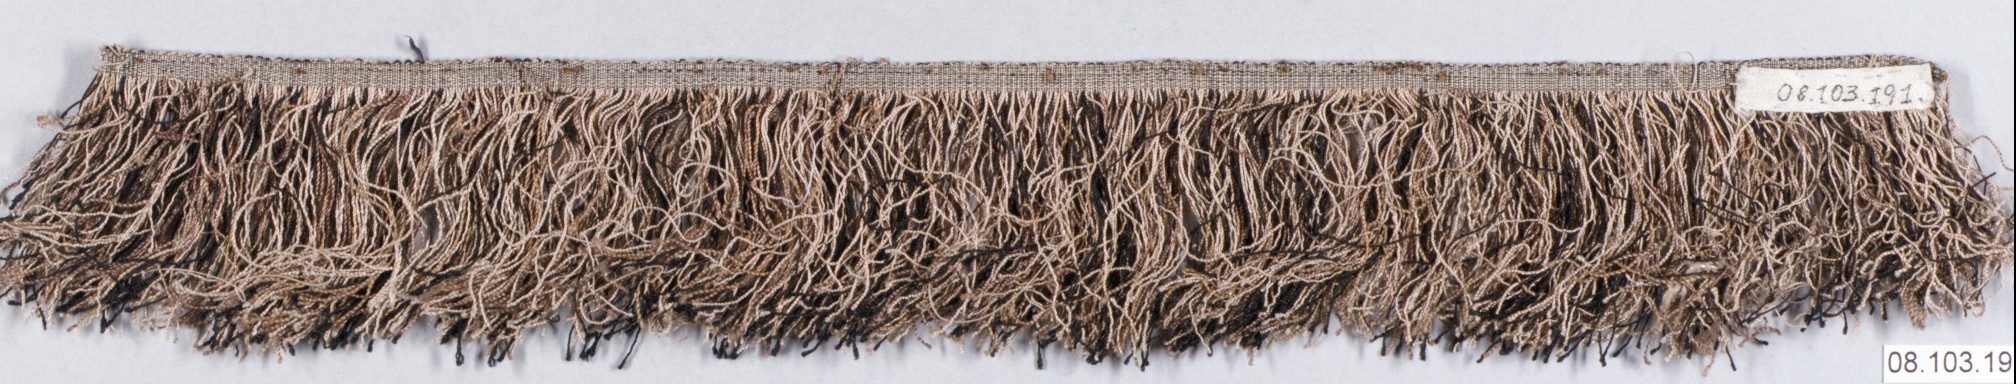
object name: fringe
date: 1801-1900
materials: silk